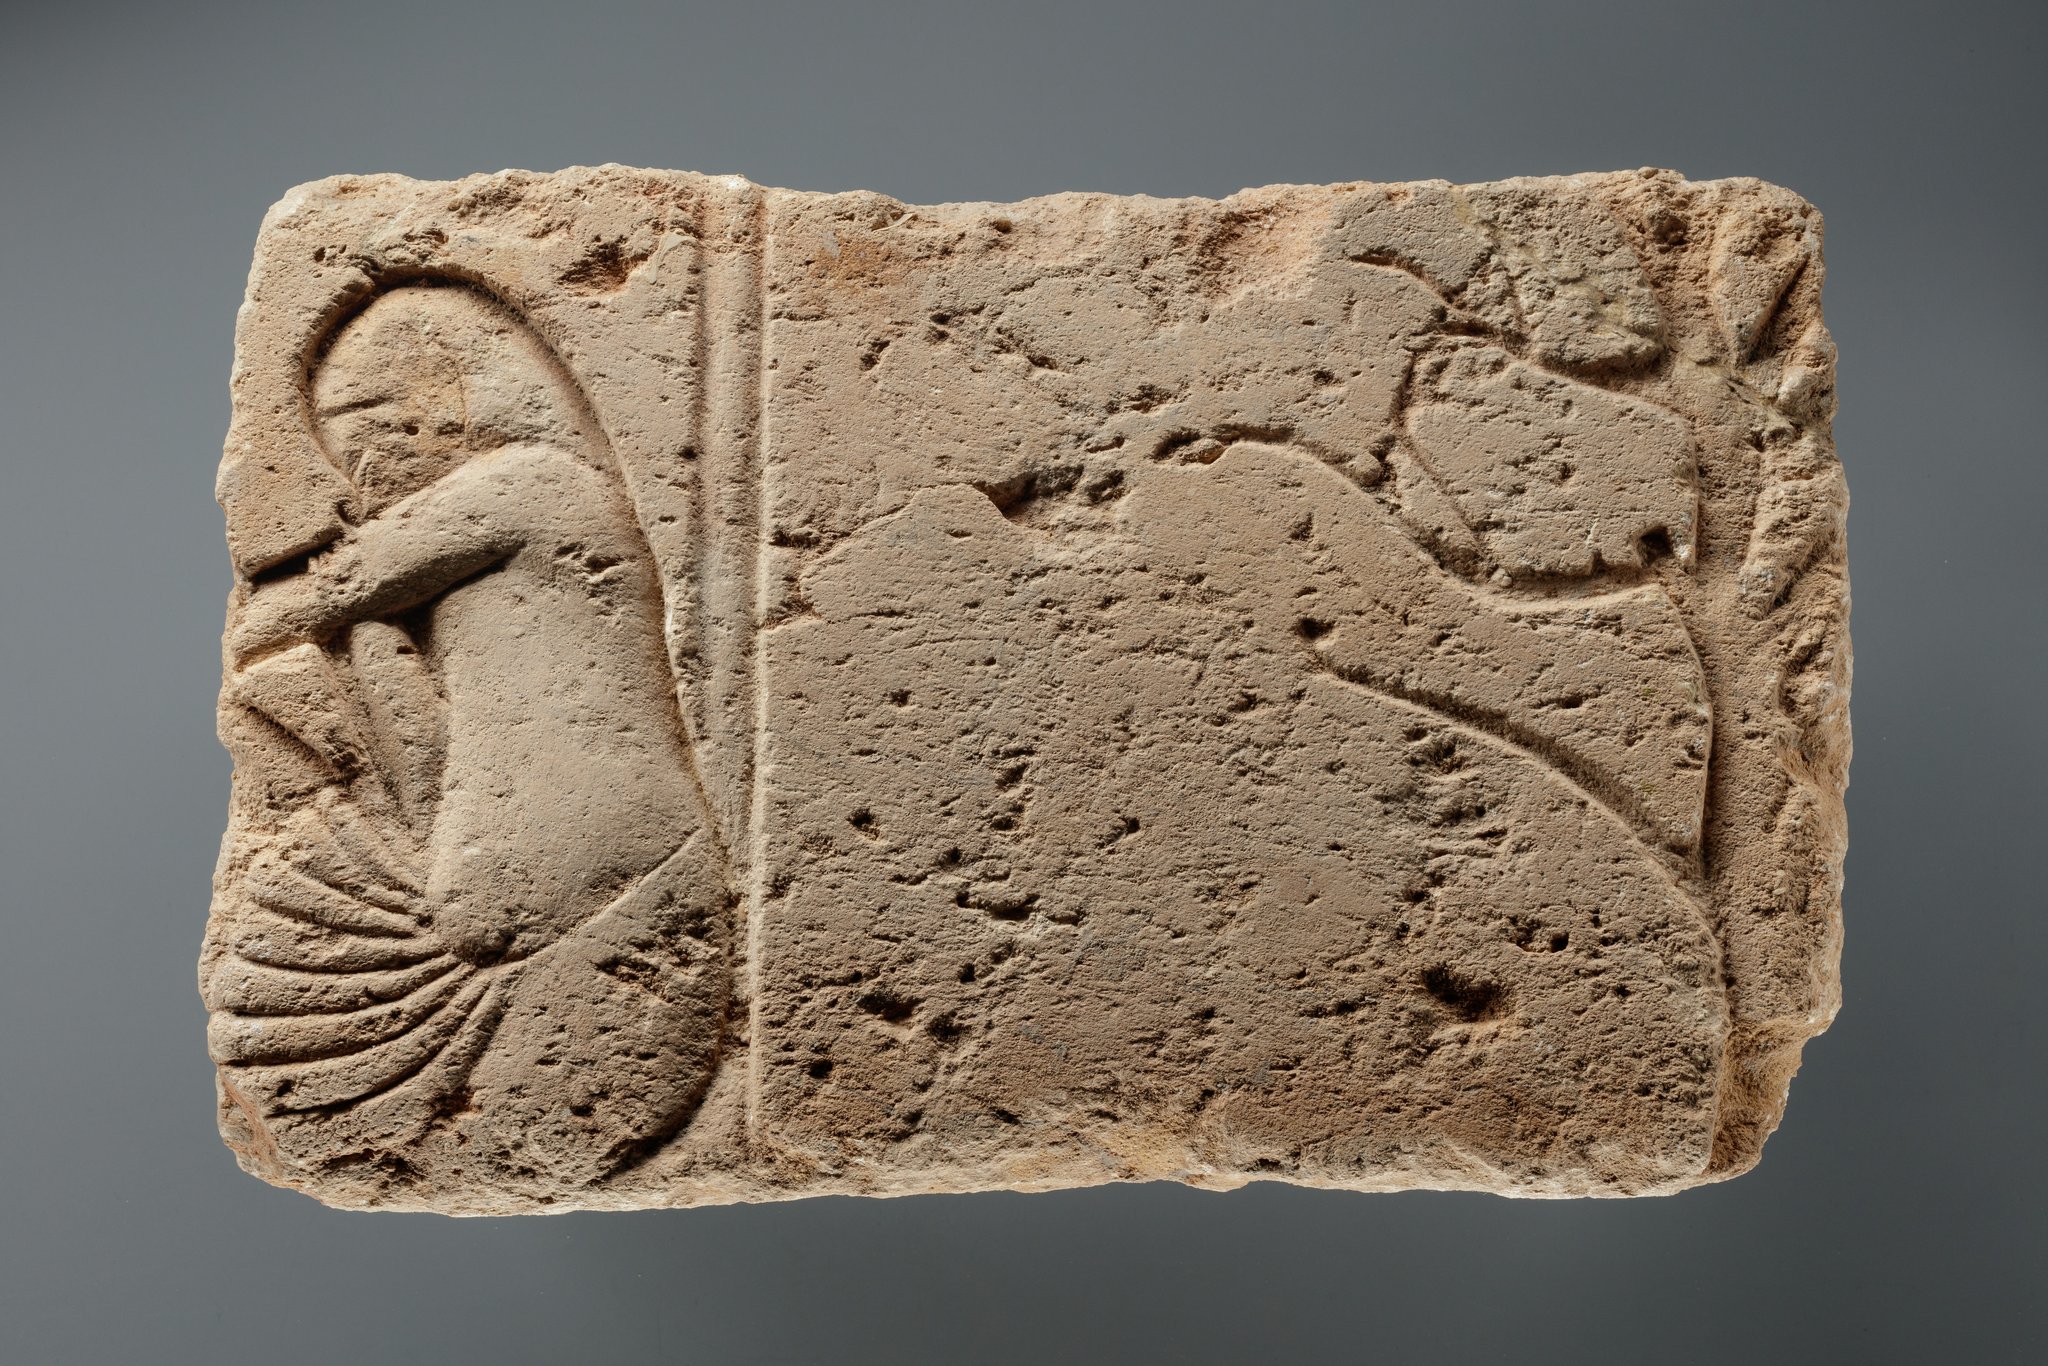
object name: relief, sleeping man. talatat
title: Relief Block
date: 1353-1323 BCE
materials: limestone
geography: egypt